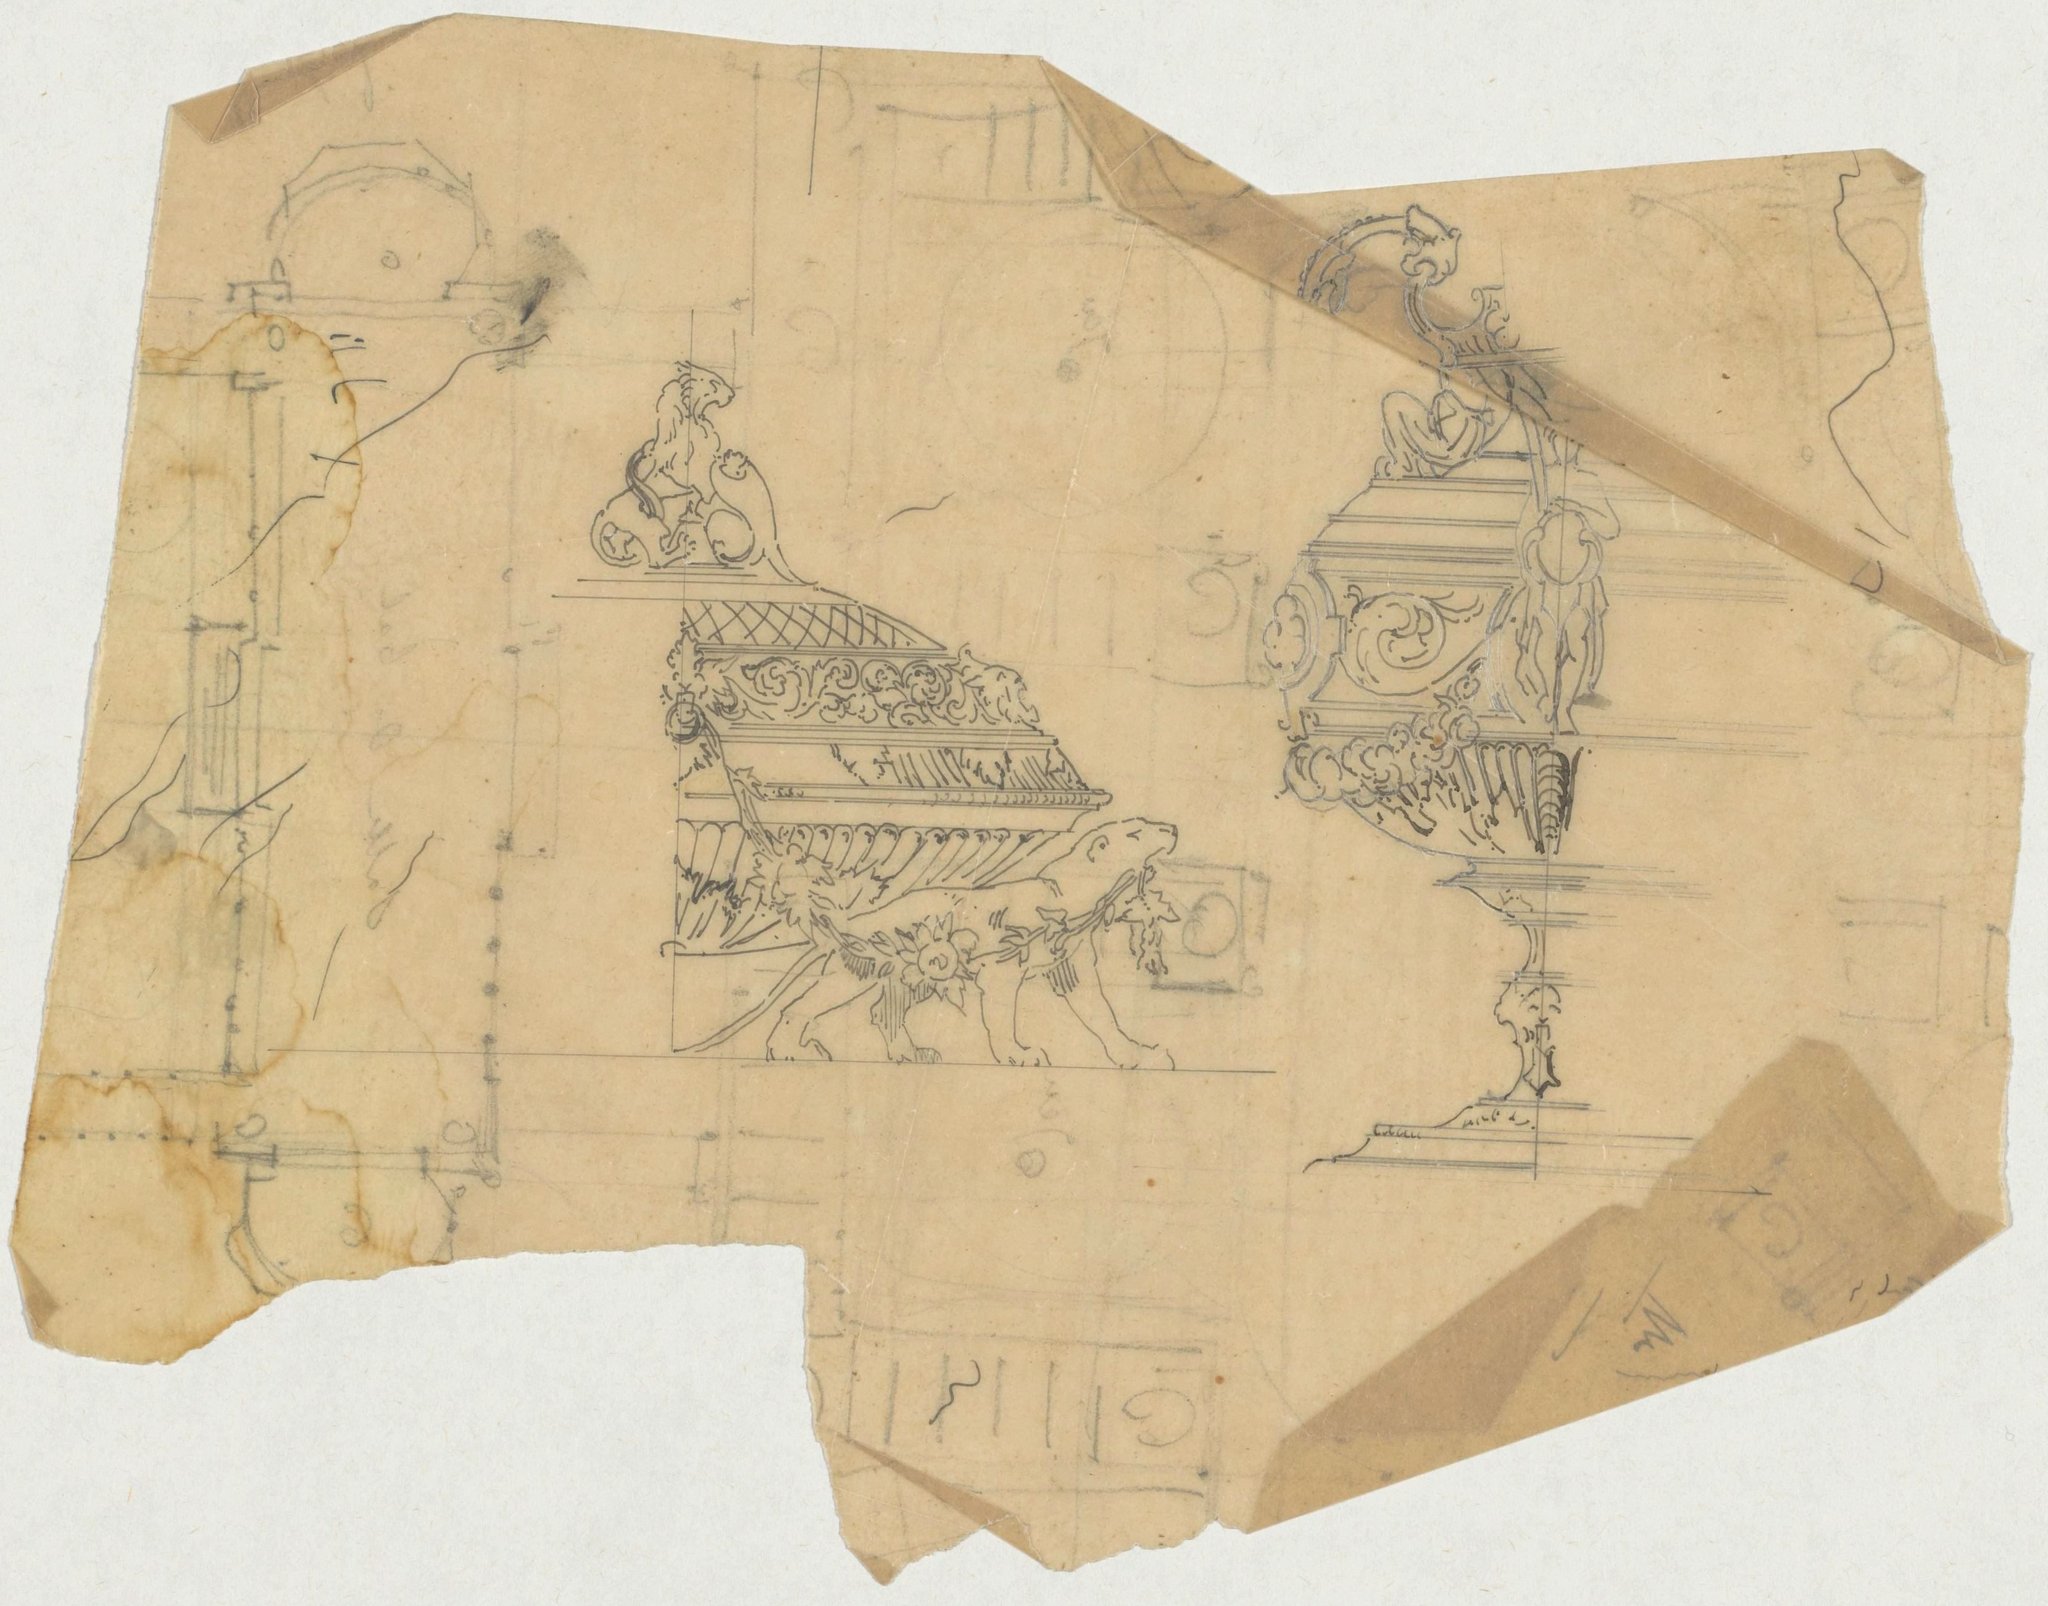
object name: design drawing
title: Terrine en coupe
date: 1830-1850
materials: graphite, paper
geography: paris